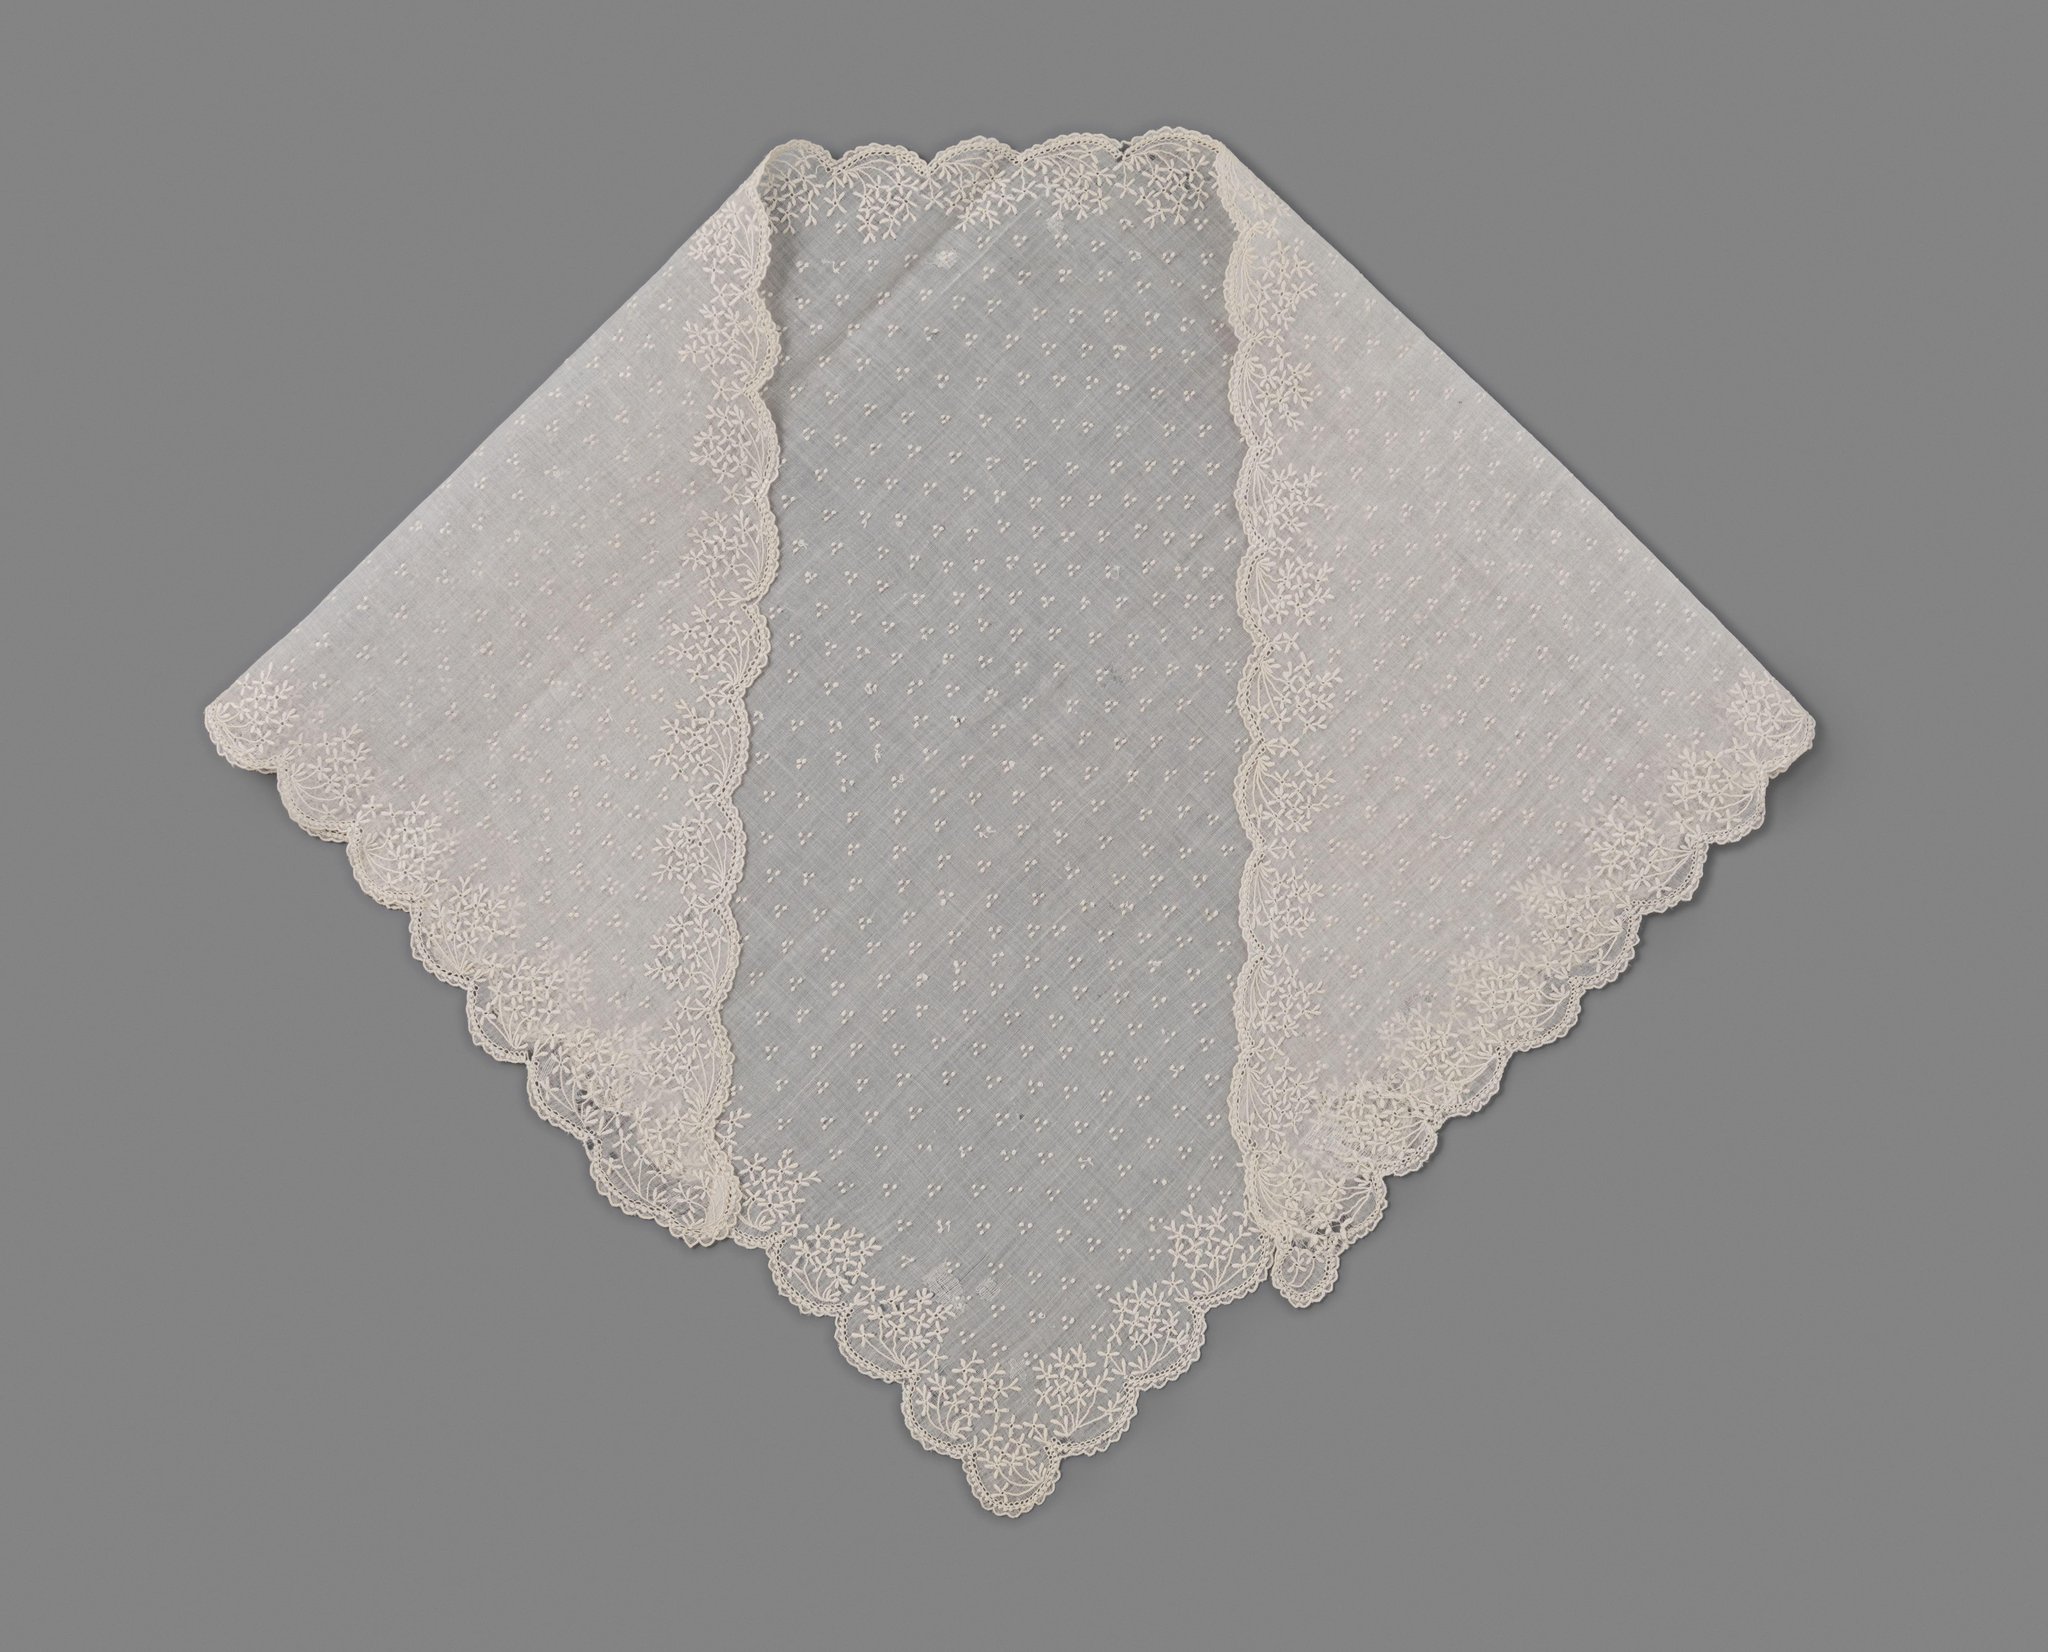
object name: womenswear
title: Fichu van linnenbatist, driehoekig en geschulpt, met een genopt fond en langs de randen afgezet met een versiering van bloemboeketten van witte katoen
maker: Anonymous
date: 1800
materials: cotton, linen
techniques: embroidered, weave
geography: netherlands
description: Fichu van linnen batist, driehoekig en geschulpt, met een genopt fond en langs de randen afgezet met een versiering van bloemboeketten van witte katoen. Versiering: het middenveld heeft een strooimotief van drie kleine noppen. In de schulpen zijn liggende bloemboeketten geborduurd afgewisseld met één staande bloem op de inwaartse punt. De harten van de bloemen en een parelrand daaronder zijn opengwerkt.